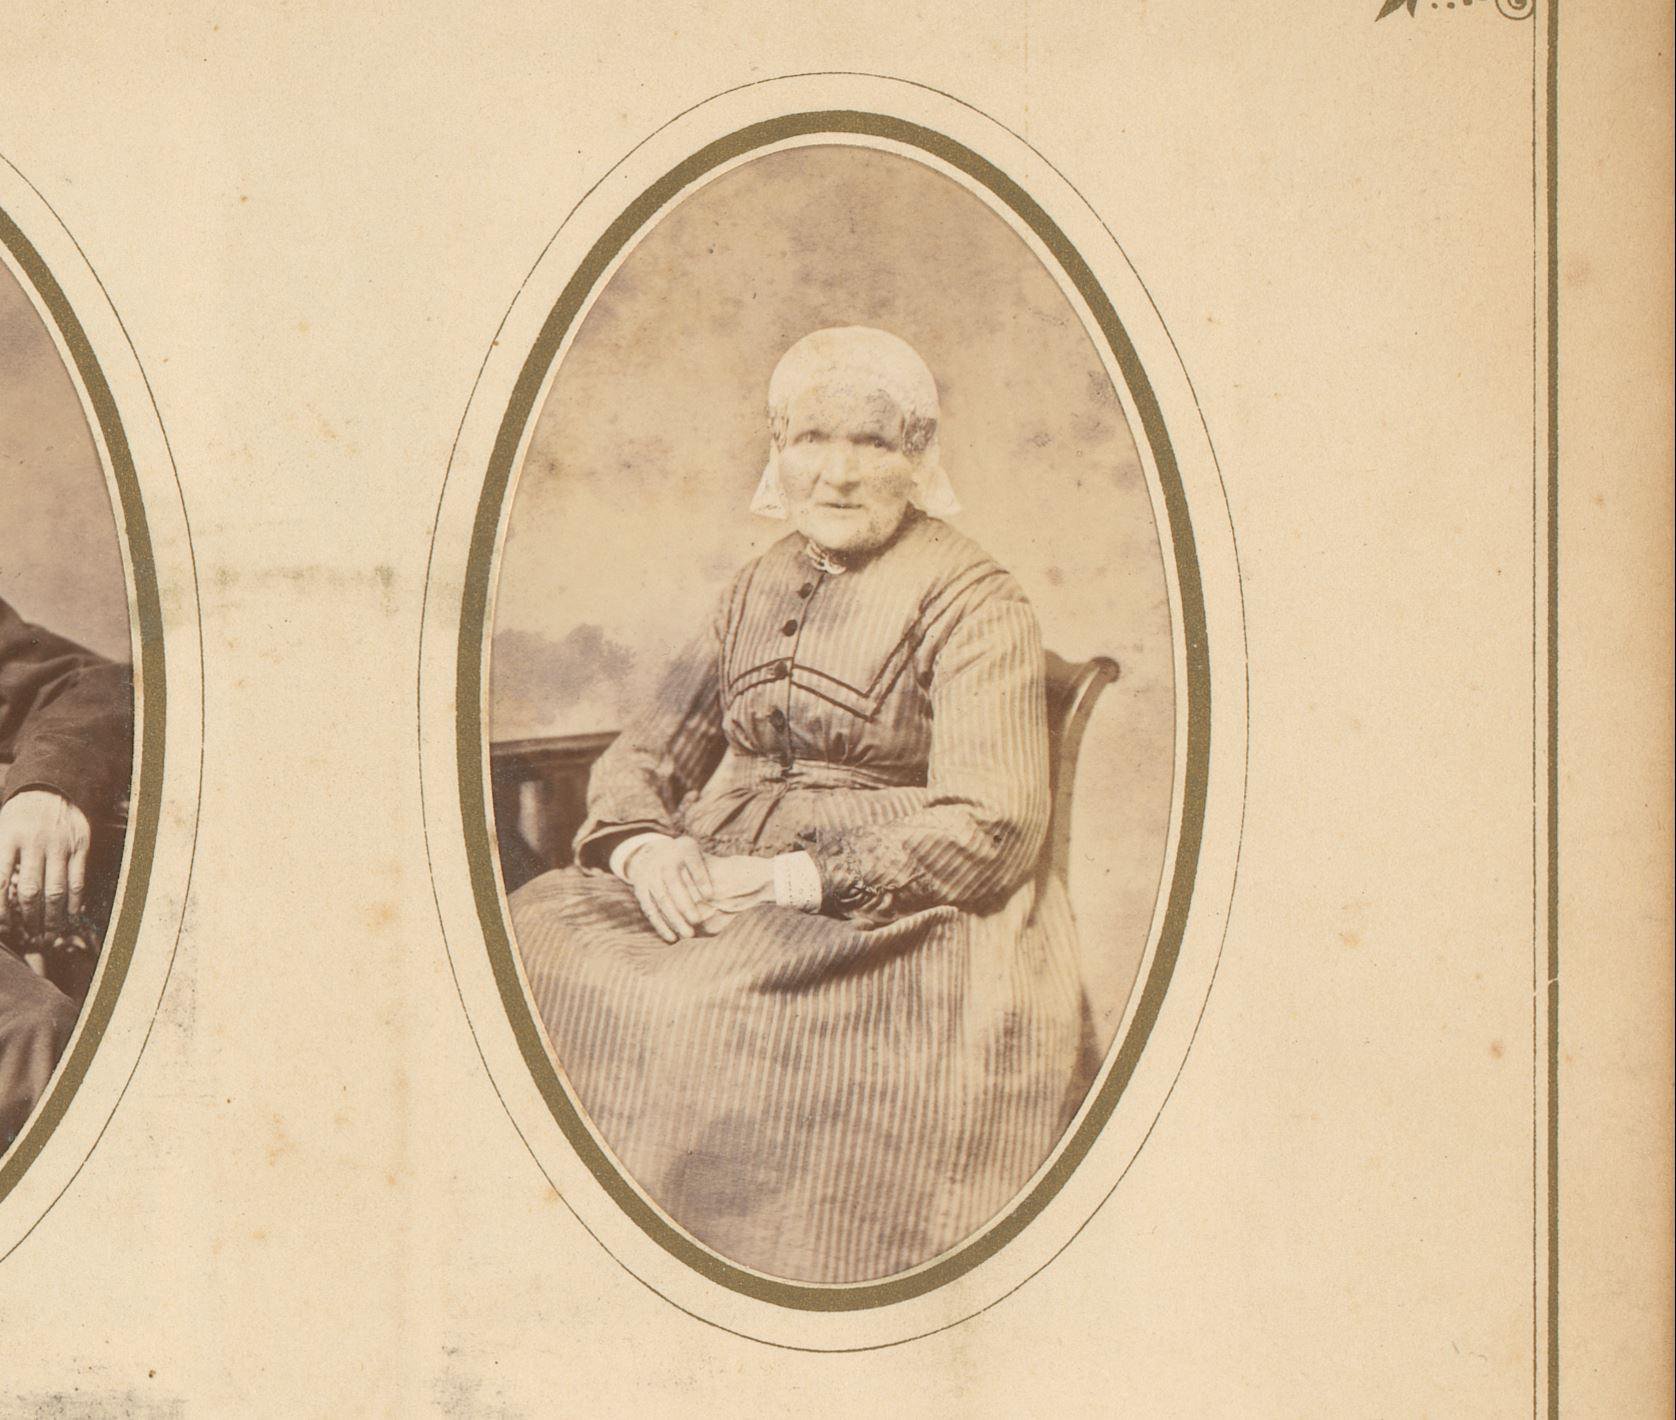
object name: photograph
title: Portret van een zittende oude vrouw met witte klederdrachtmuts en oorijzers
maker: thomas martin staas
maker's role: fotograaf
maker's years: 1844-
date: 1865-1895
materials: cardboard, photographic support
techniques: albumen print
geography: leeuwarden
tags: sitting figure - aa - female human figure, historical persons - bb - woman, old woman, head-gear: cap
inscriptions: inscription: ‘Z. M. des Konings der Nederlanden./ Th. M. Staas./ FIRMA:/ E. FUCHS,/ LEEUWARDEN./ Voor nabestellingen worden/ alle negativen bewaard.’